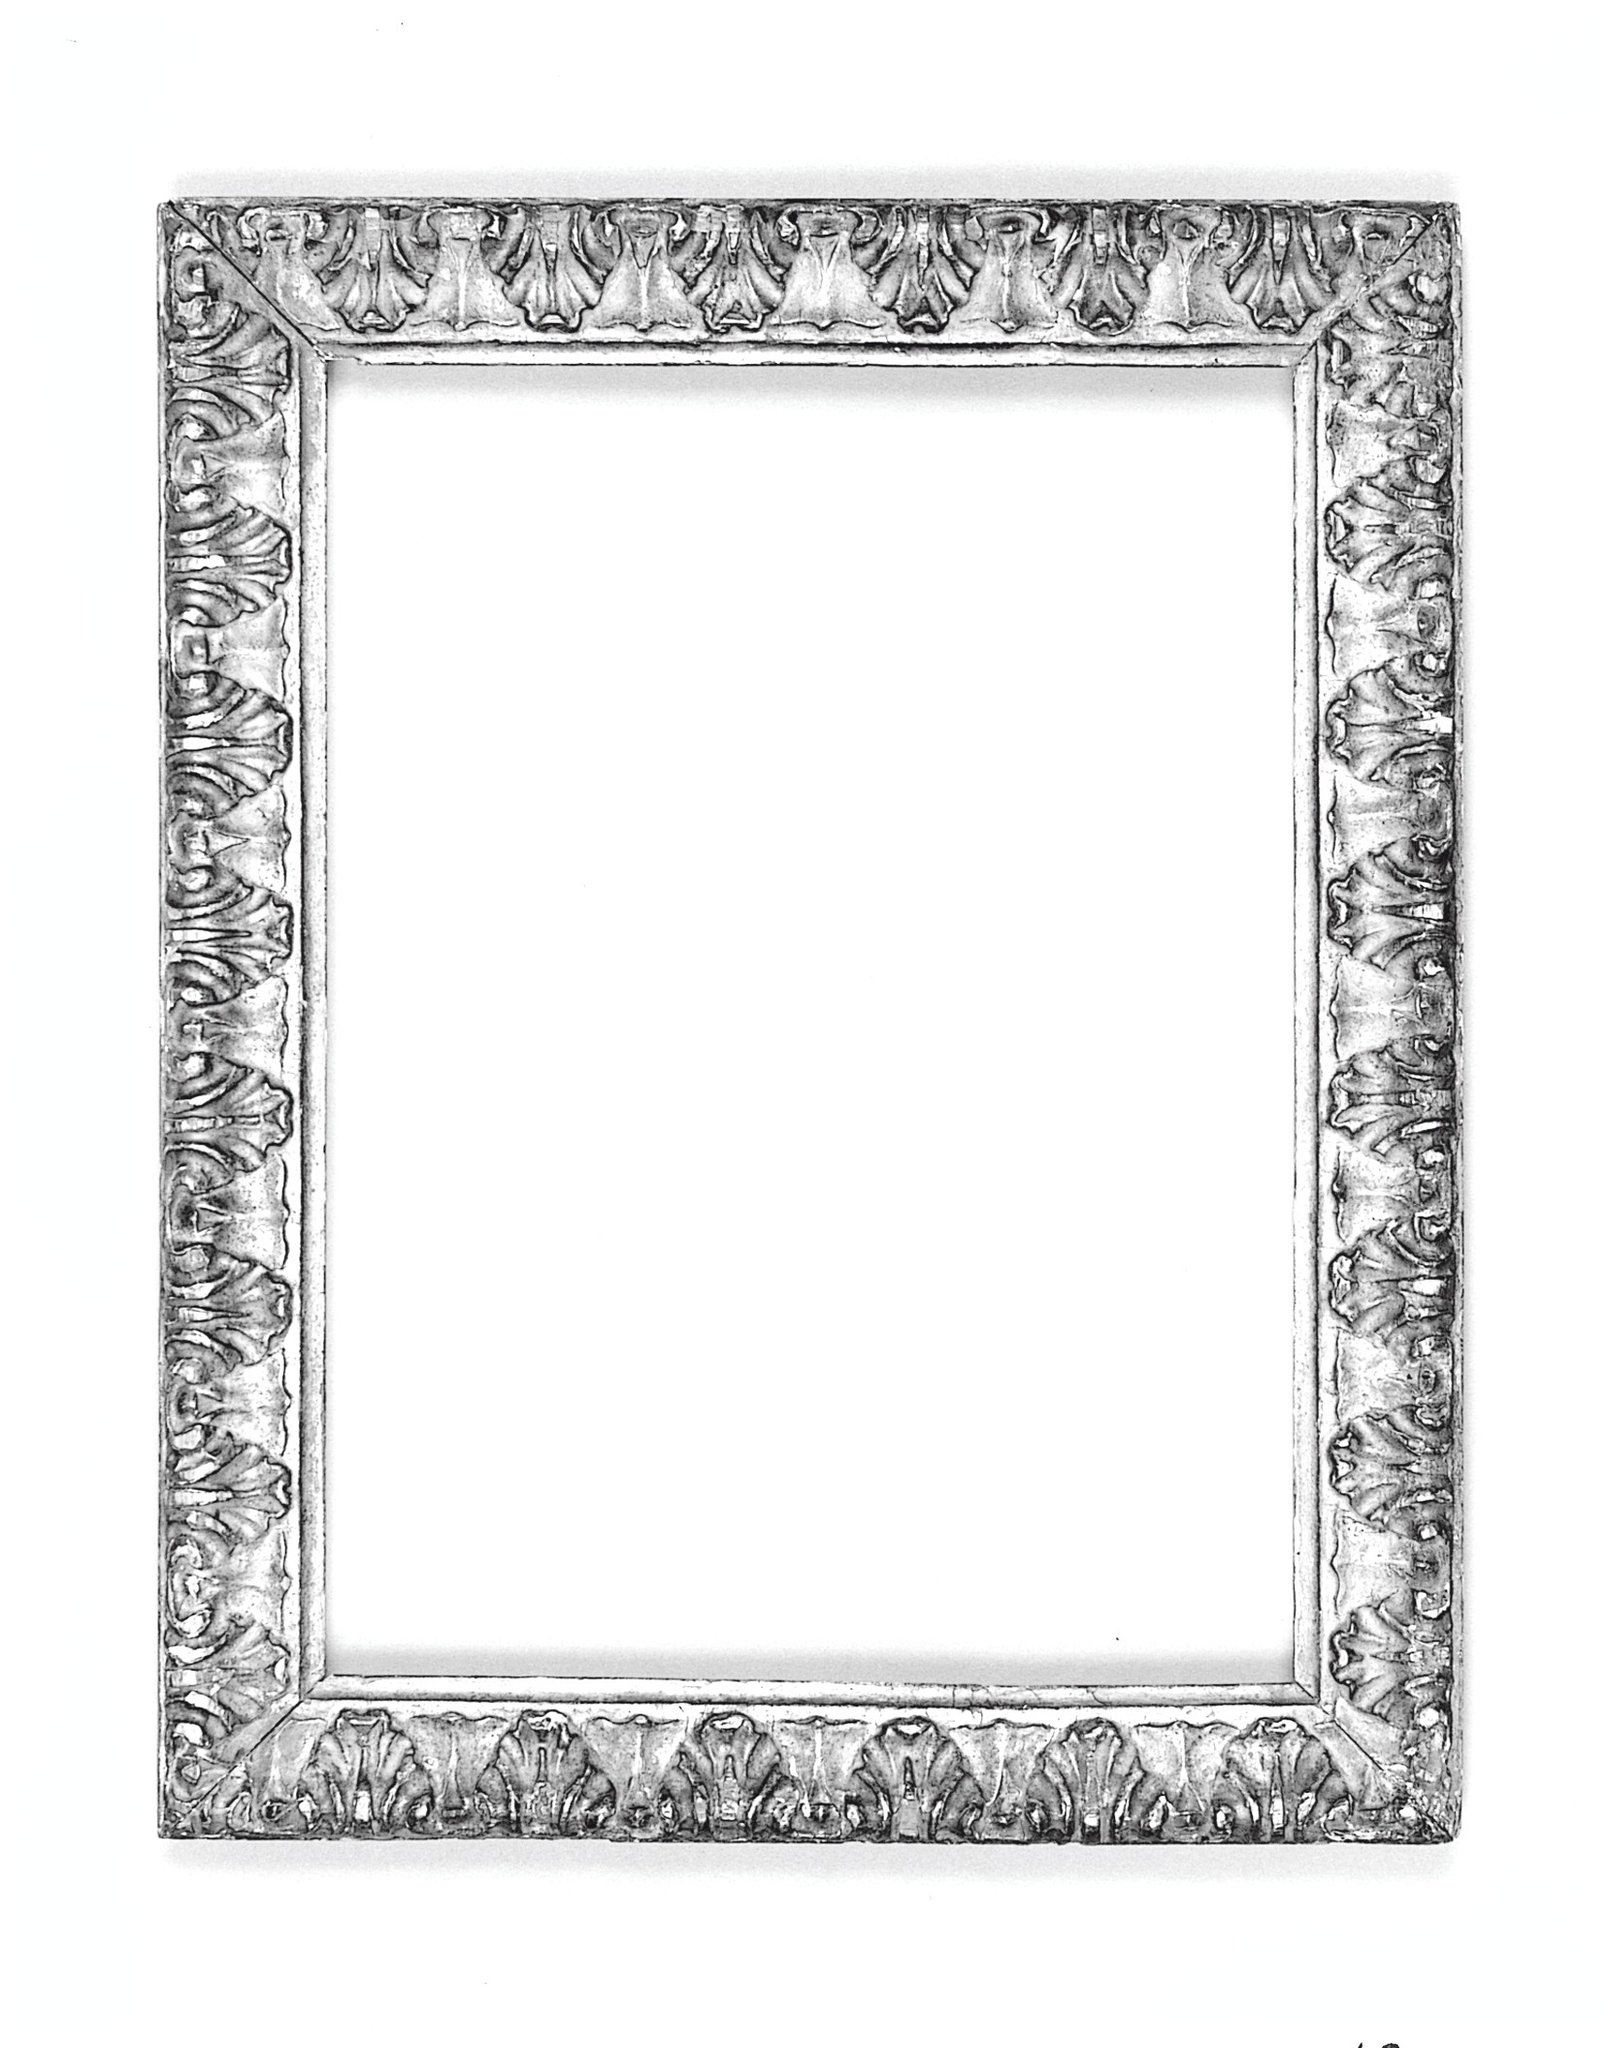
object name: frame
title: Salvator Rosa (wall) molding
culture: italian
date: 1701-1733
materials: wood